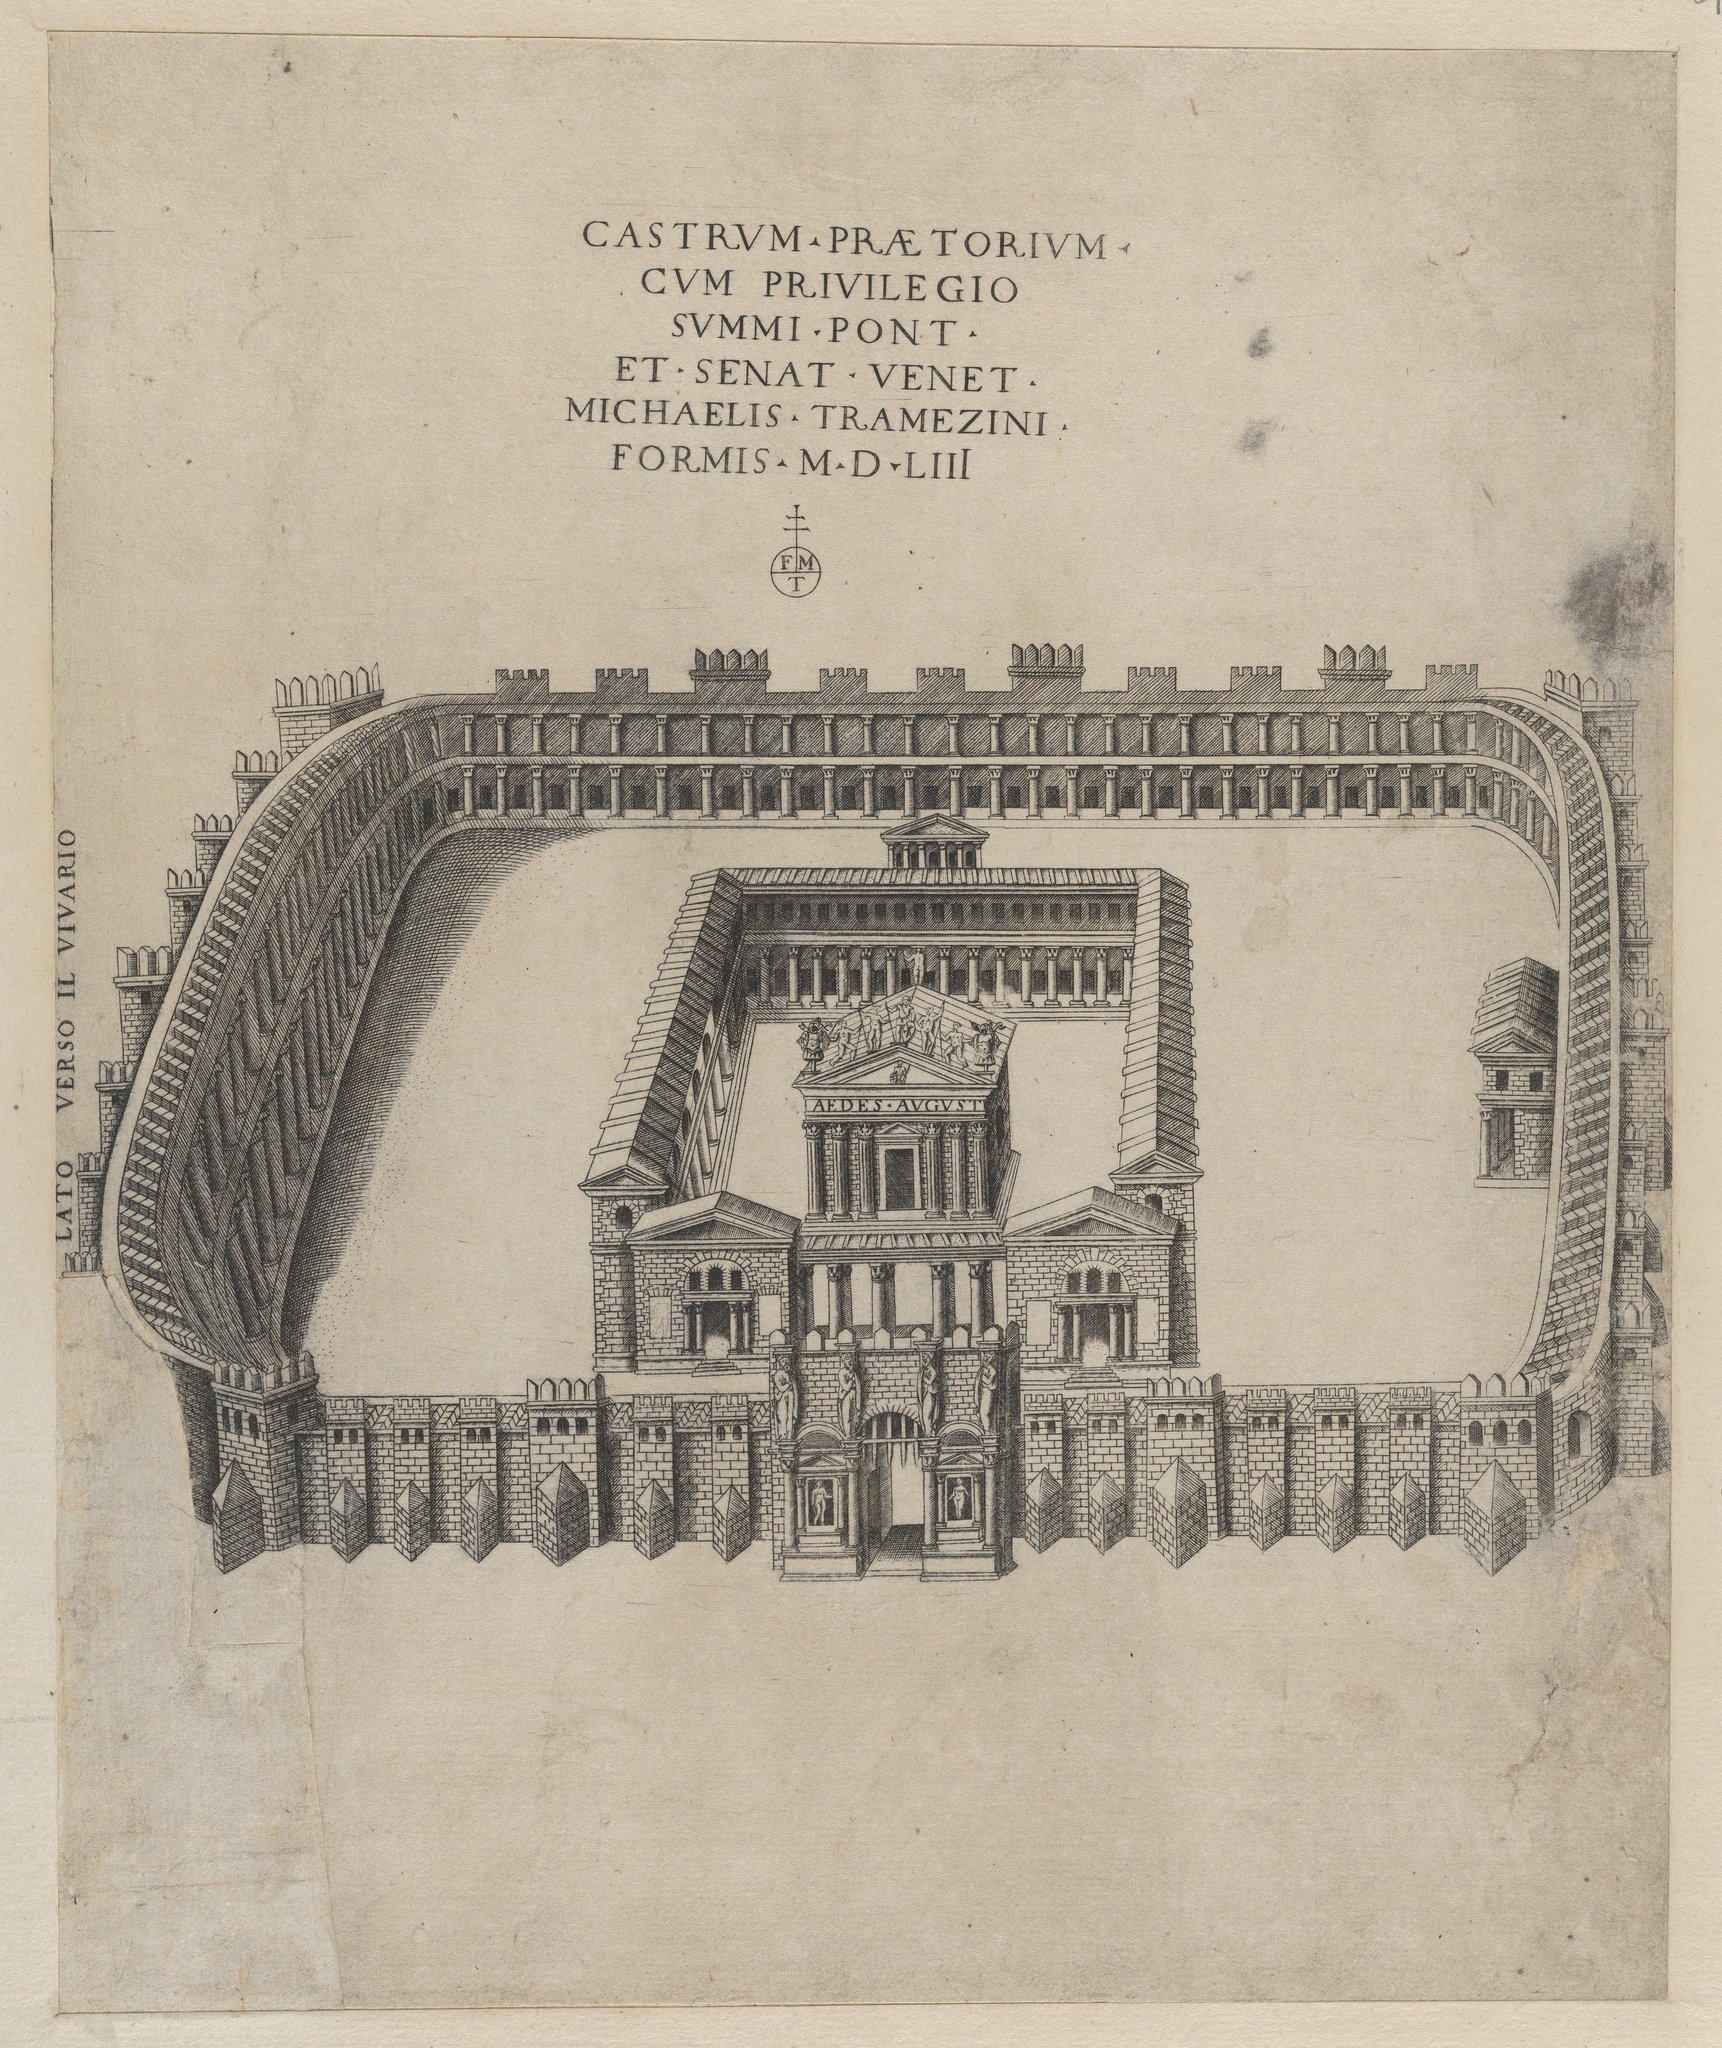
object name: print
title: Castrum, from "Speculum Romanae Magnificentiae"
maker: Anonymous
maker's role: artist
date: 1501-1600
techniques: engraving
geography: rome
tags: buildings,fortification,rome